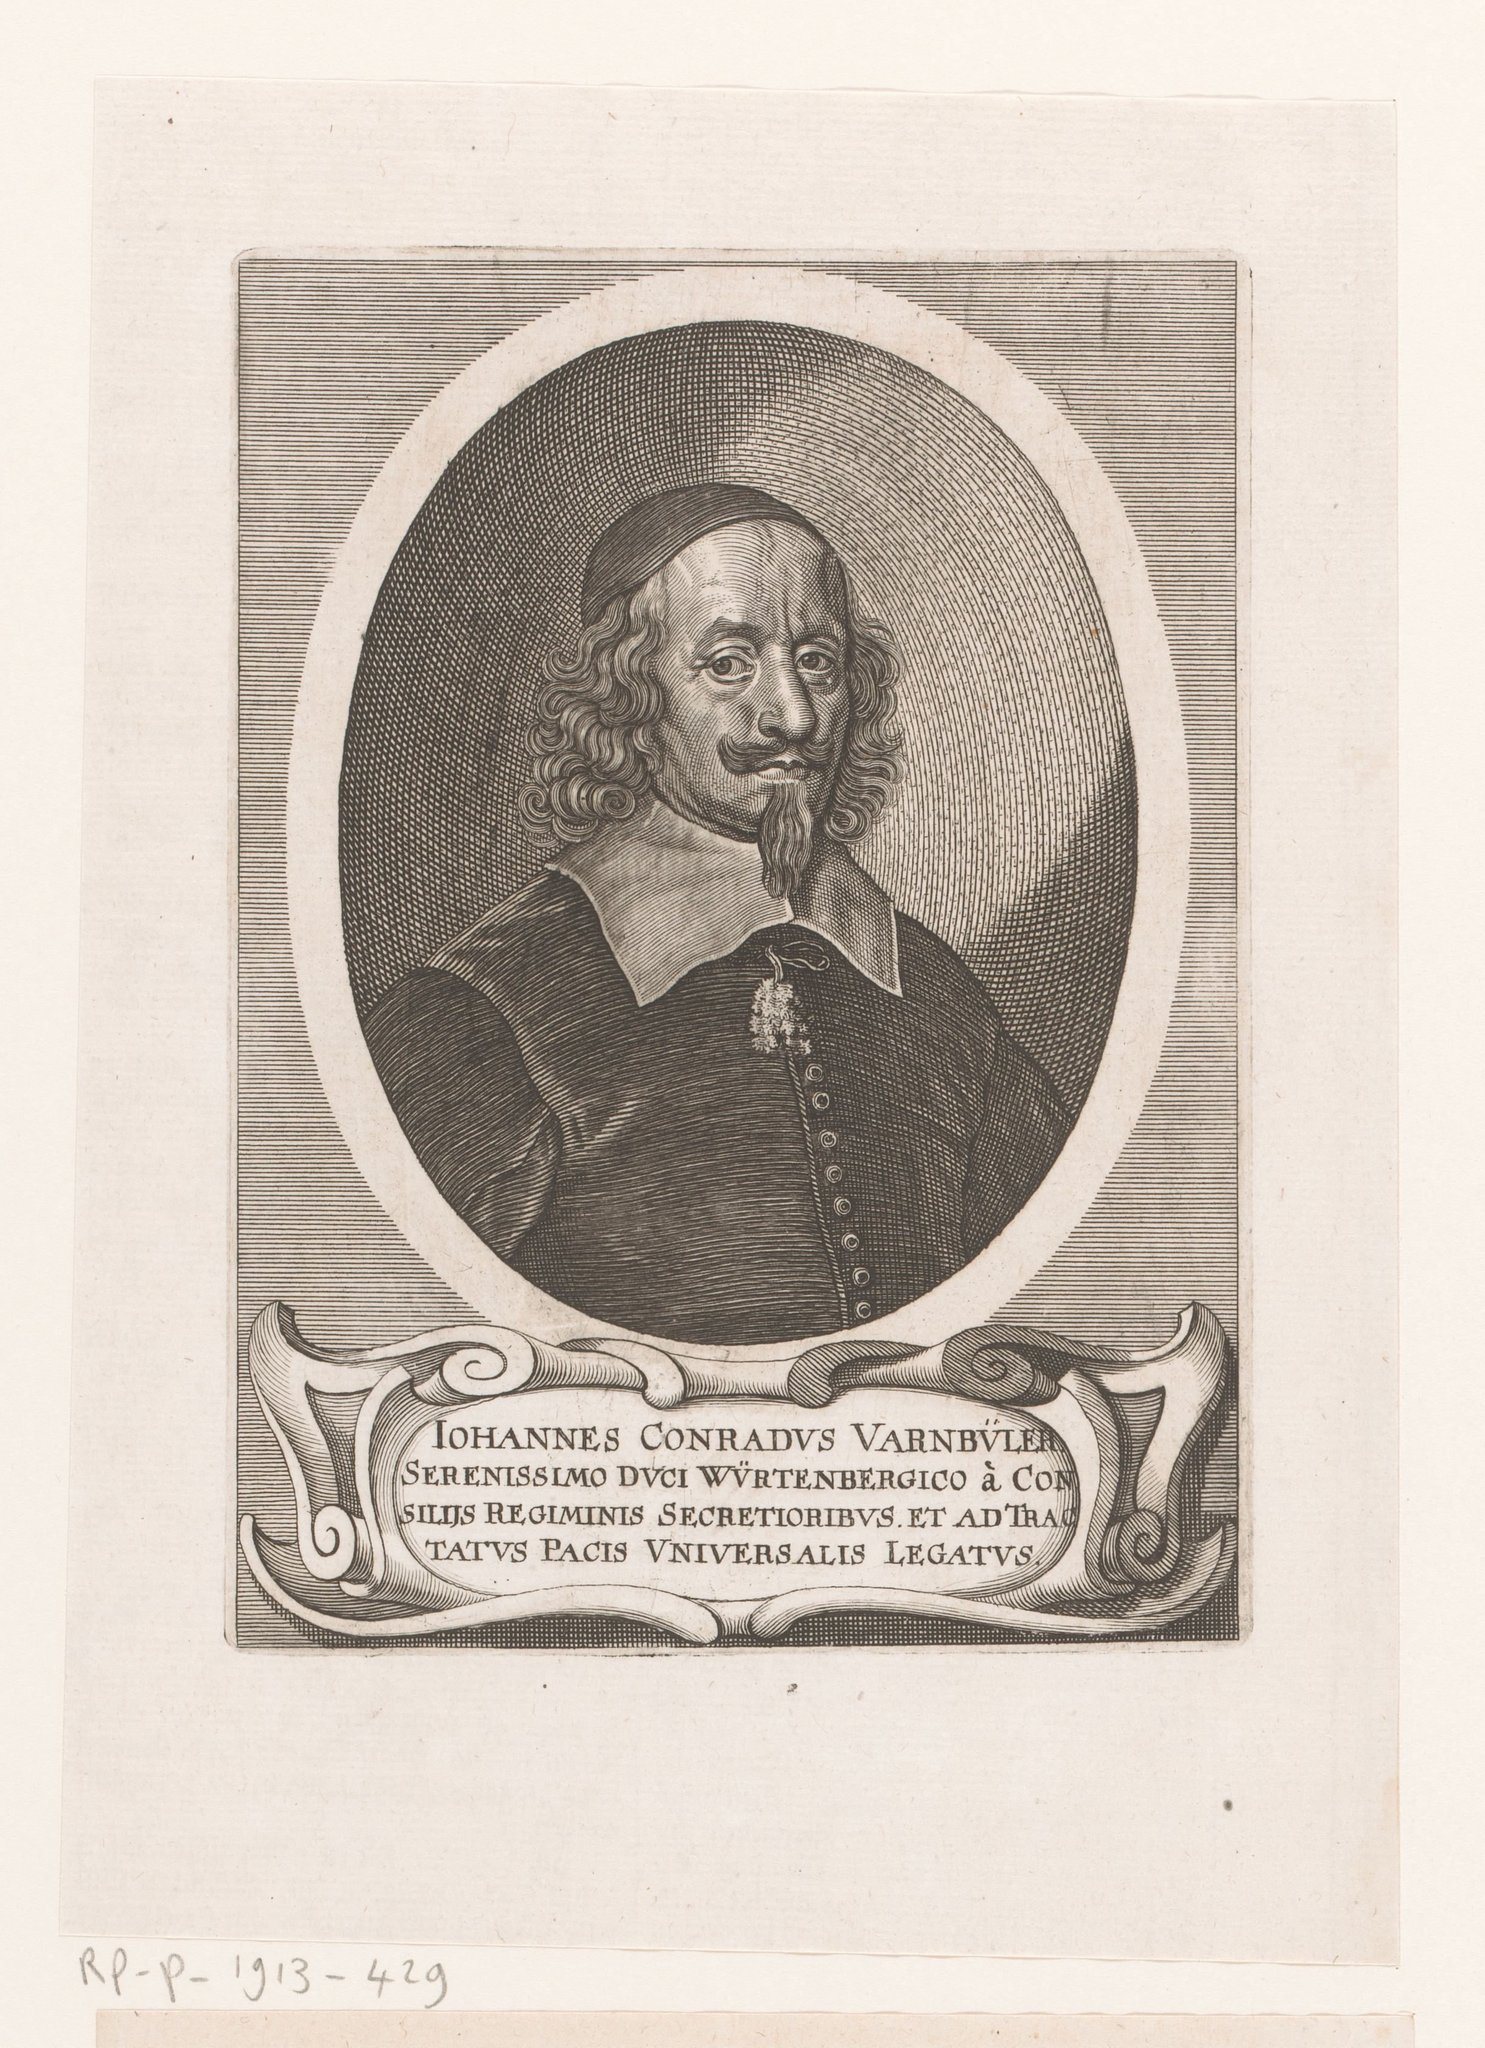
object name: book illustration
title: Portret van Johann Konrad Varnbüler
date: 1652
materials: paper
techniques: engraving, etching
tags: politician, historical persons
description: Illustratie in: J.G. Schleder. Theatrum Europaeum. Dl. 6. Frankfurt a.M., Merian, 1652. P. 660.